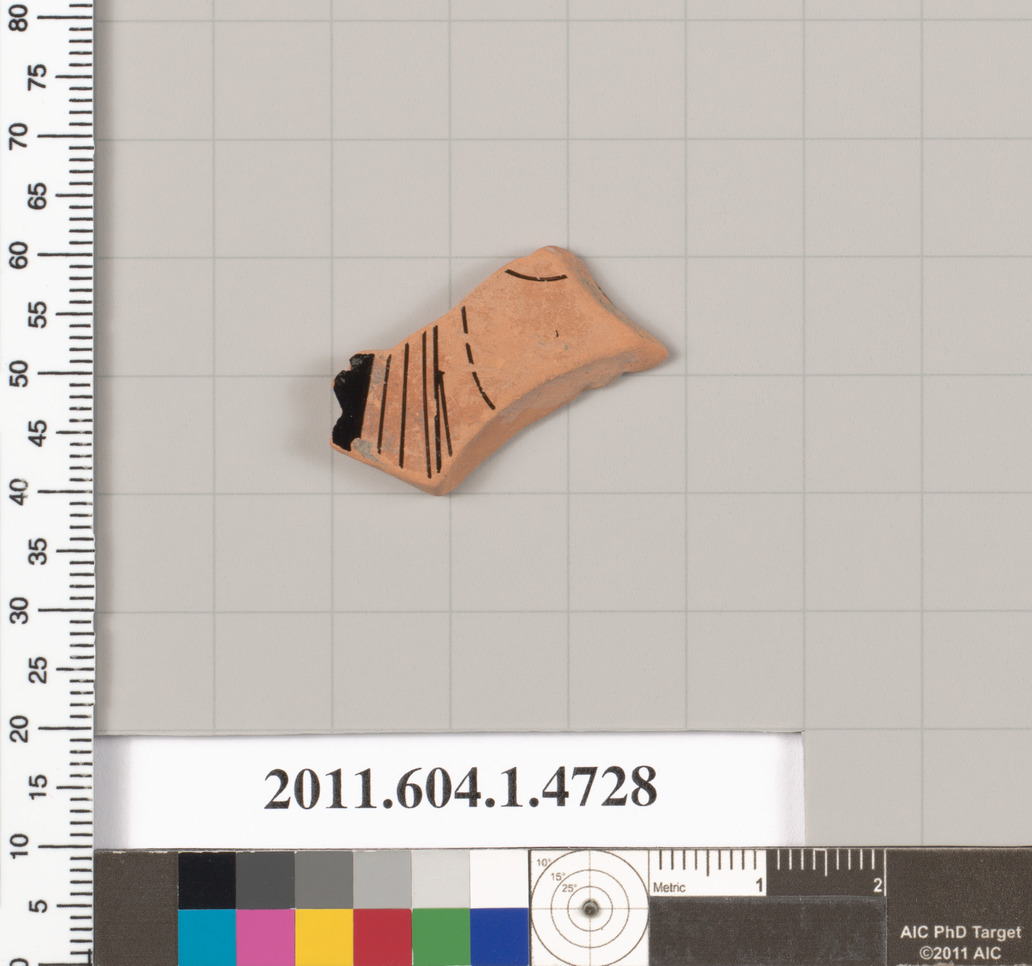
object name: kylix fragment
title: Terracotta fragment of a kylix (drinking cup)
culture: greek, attic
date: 490-470 BCE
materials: terracotta